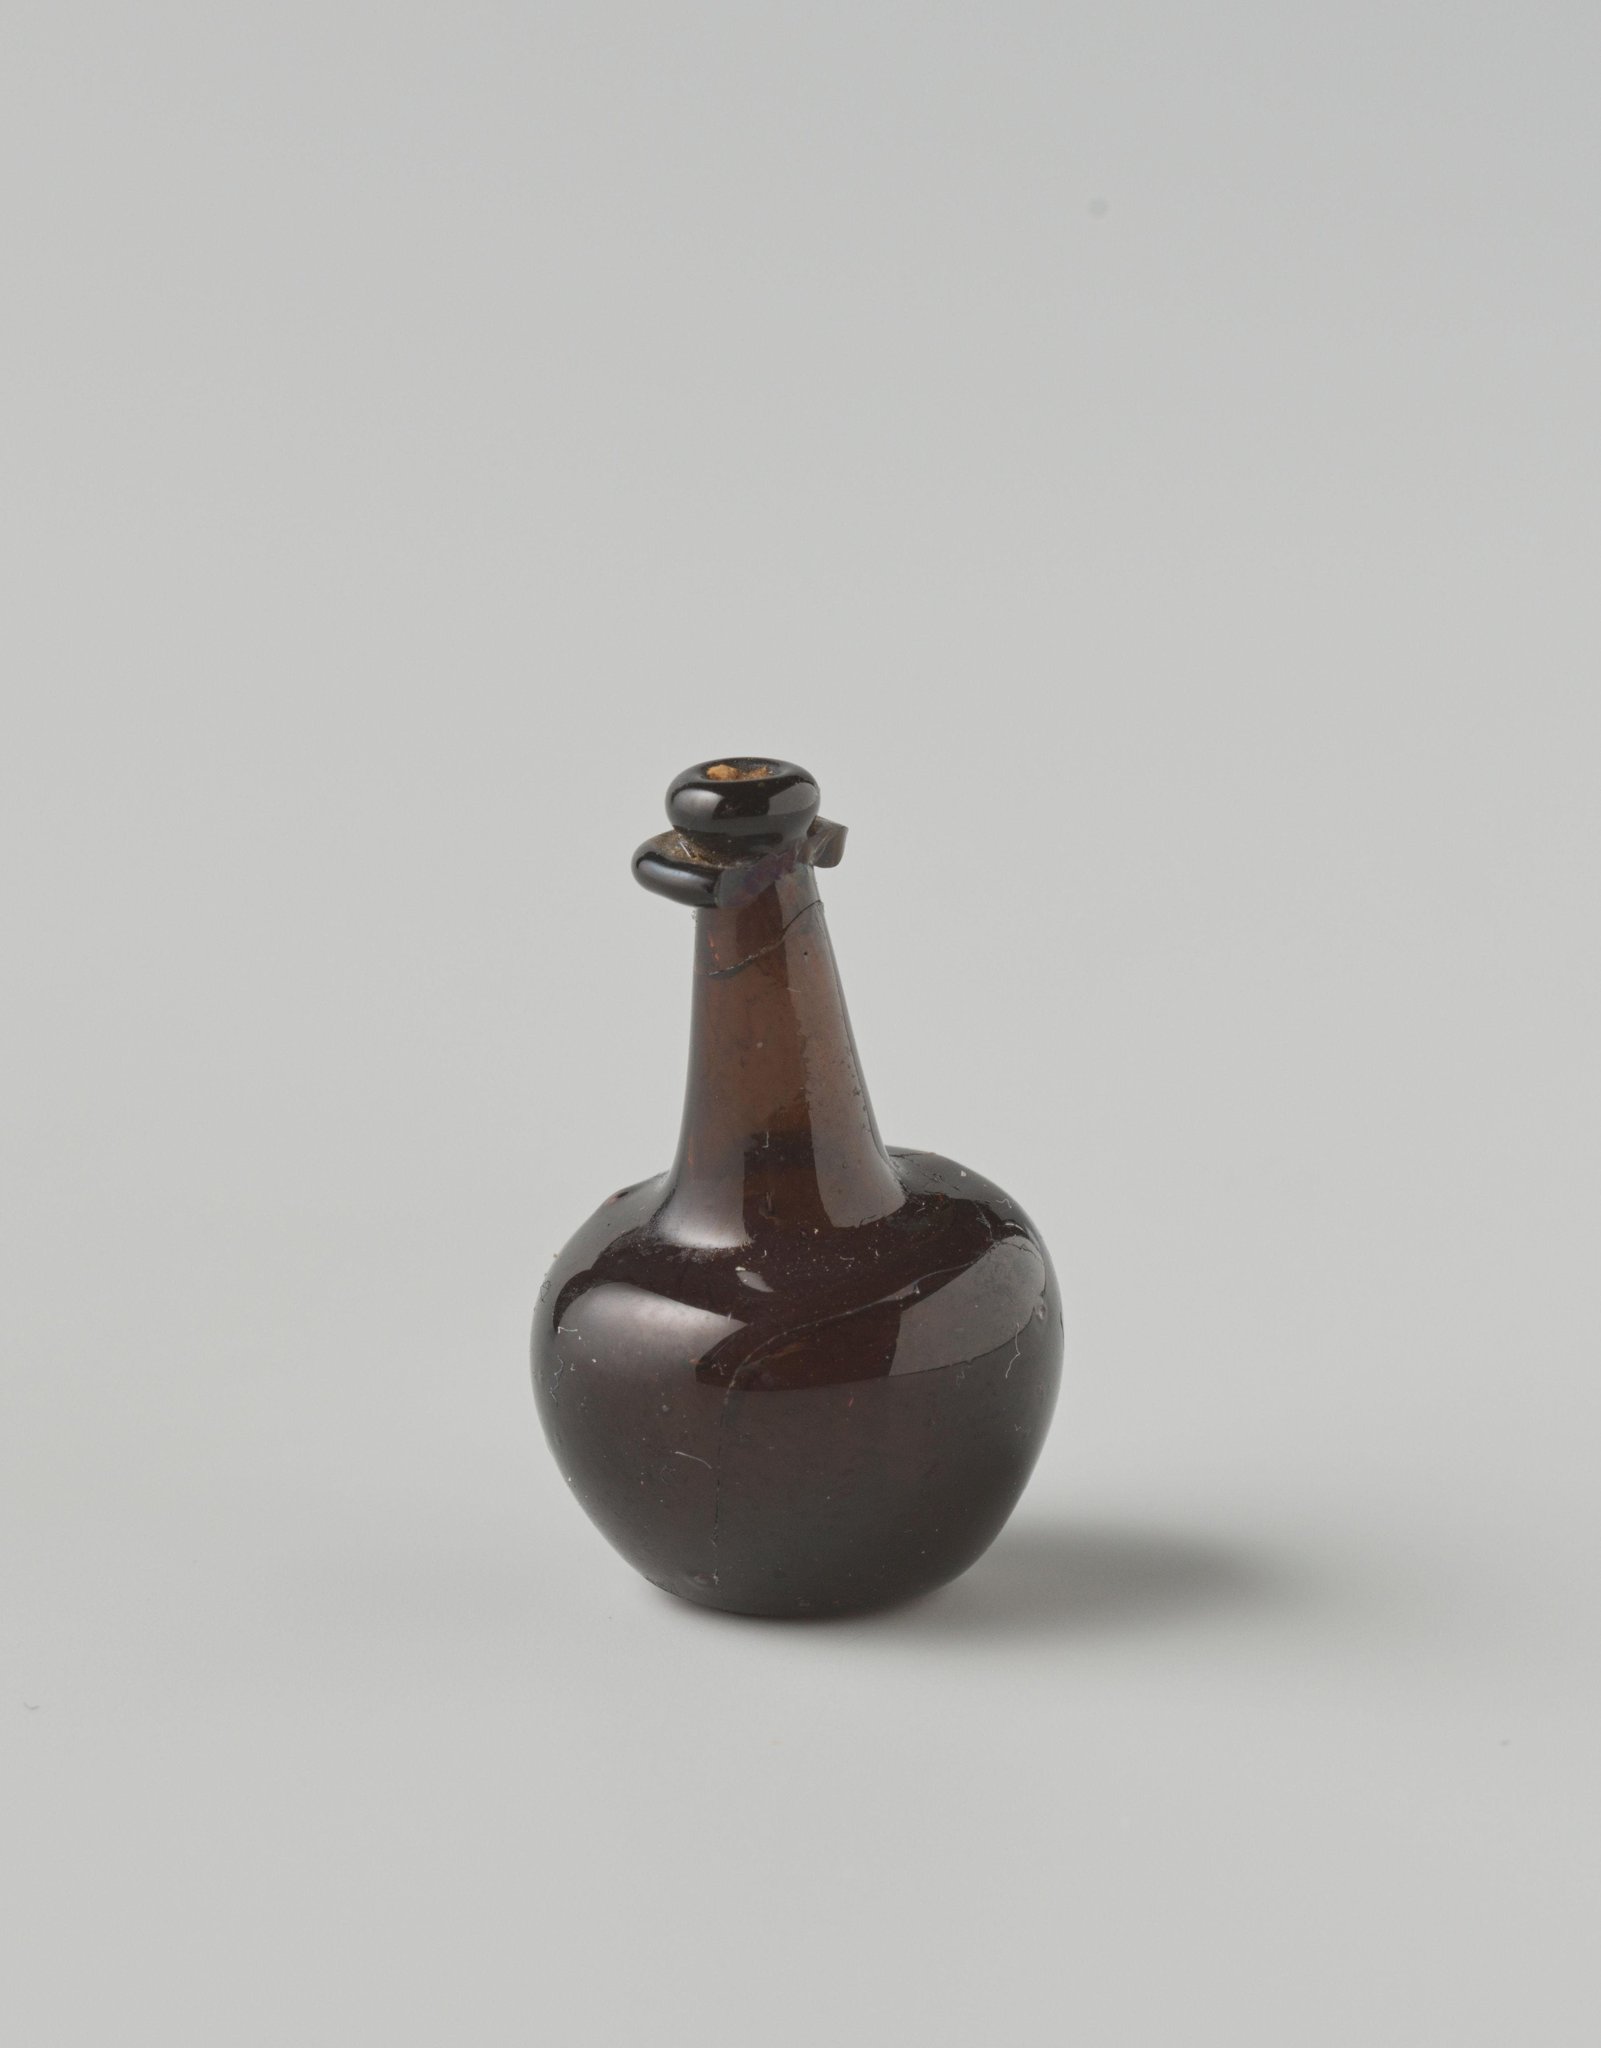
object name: miniature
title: Fles van helder azuurblauw glas; buik met ingestoken ziel, hoge hals met druipring (grotendeels afgebroken), in de halsopening een kurk.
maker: Anonymous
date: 1675-1710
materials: cork, glass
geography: amsterdam